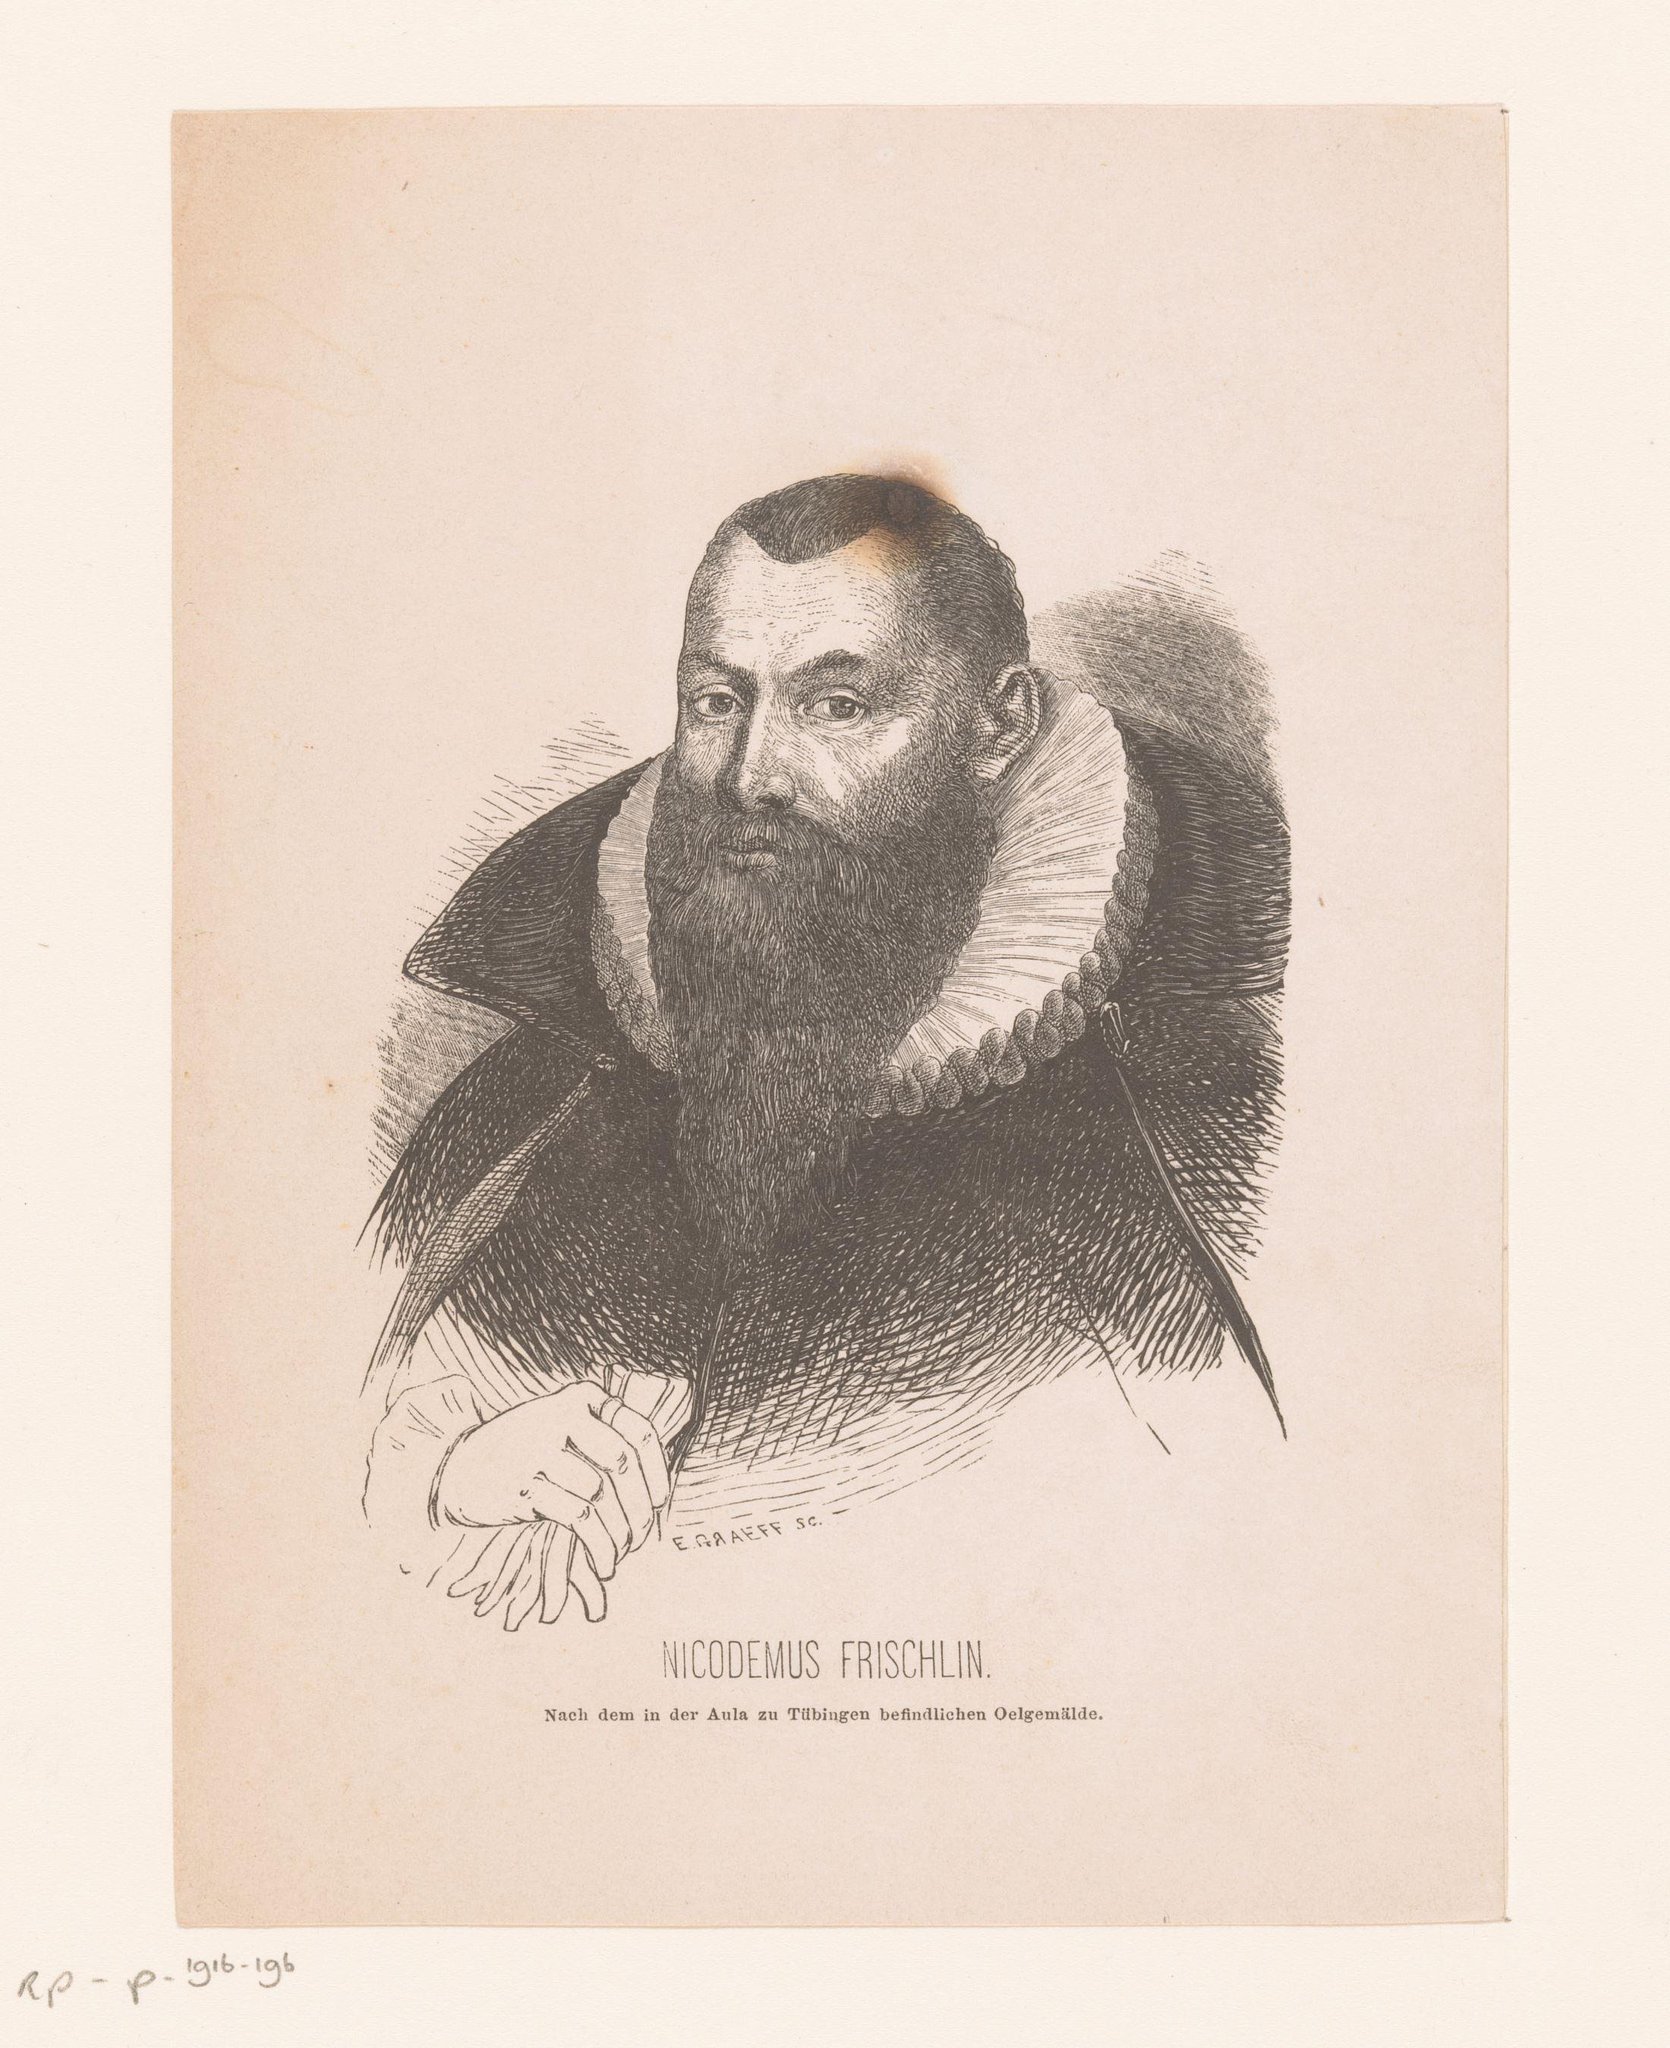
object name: print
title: Portret van Nicodemus Frischlin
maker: engelhardt graeff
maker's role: print maker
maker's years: 1807-1878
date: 1817-1878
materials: paper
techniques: engraving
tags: historical persons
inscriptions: collector's mark: Lugt 2228